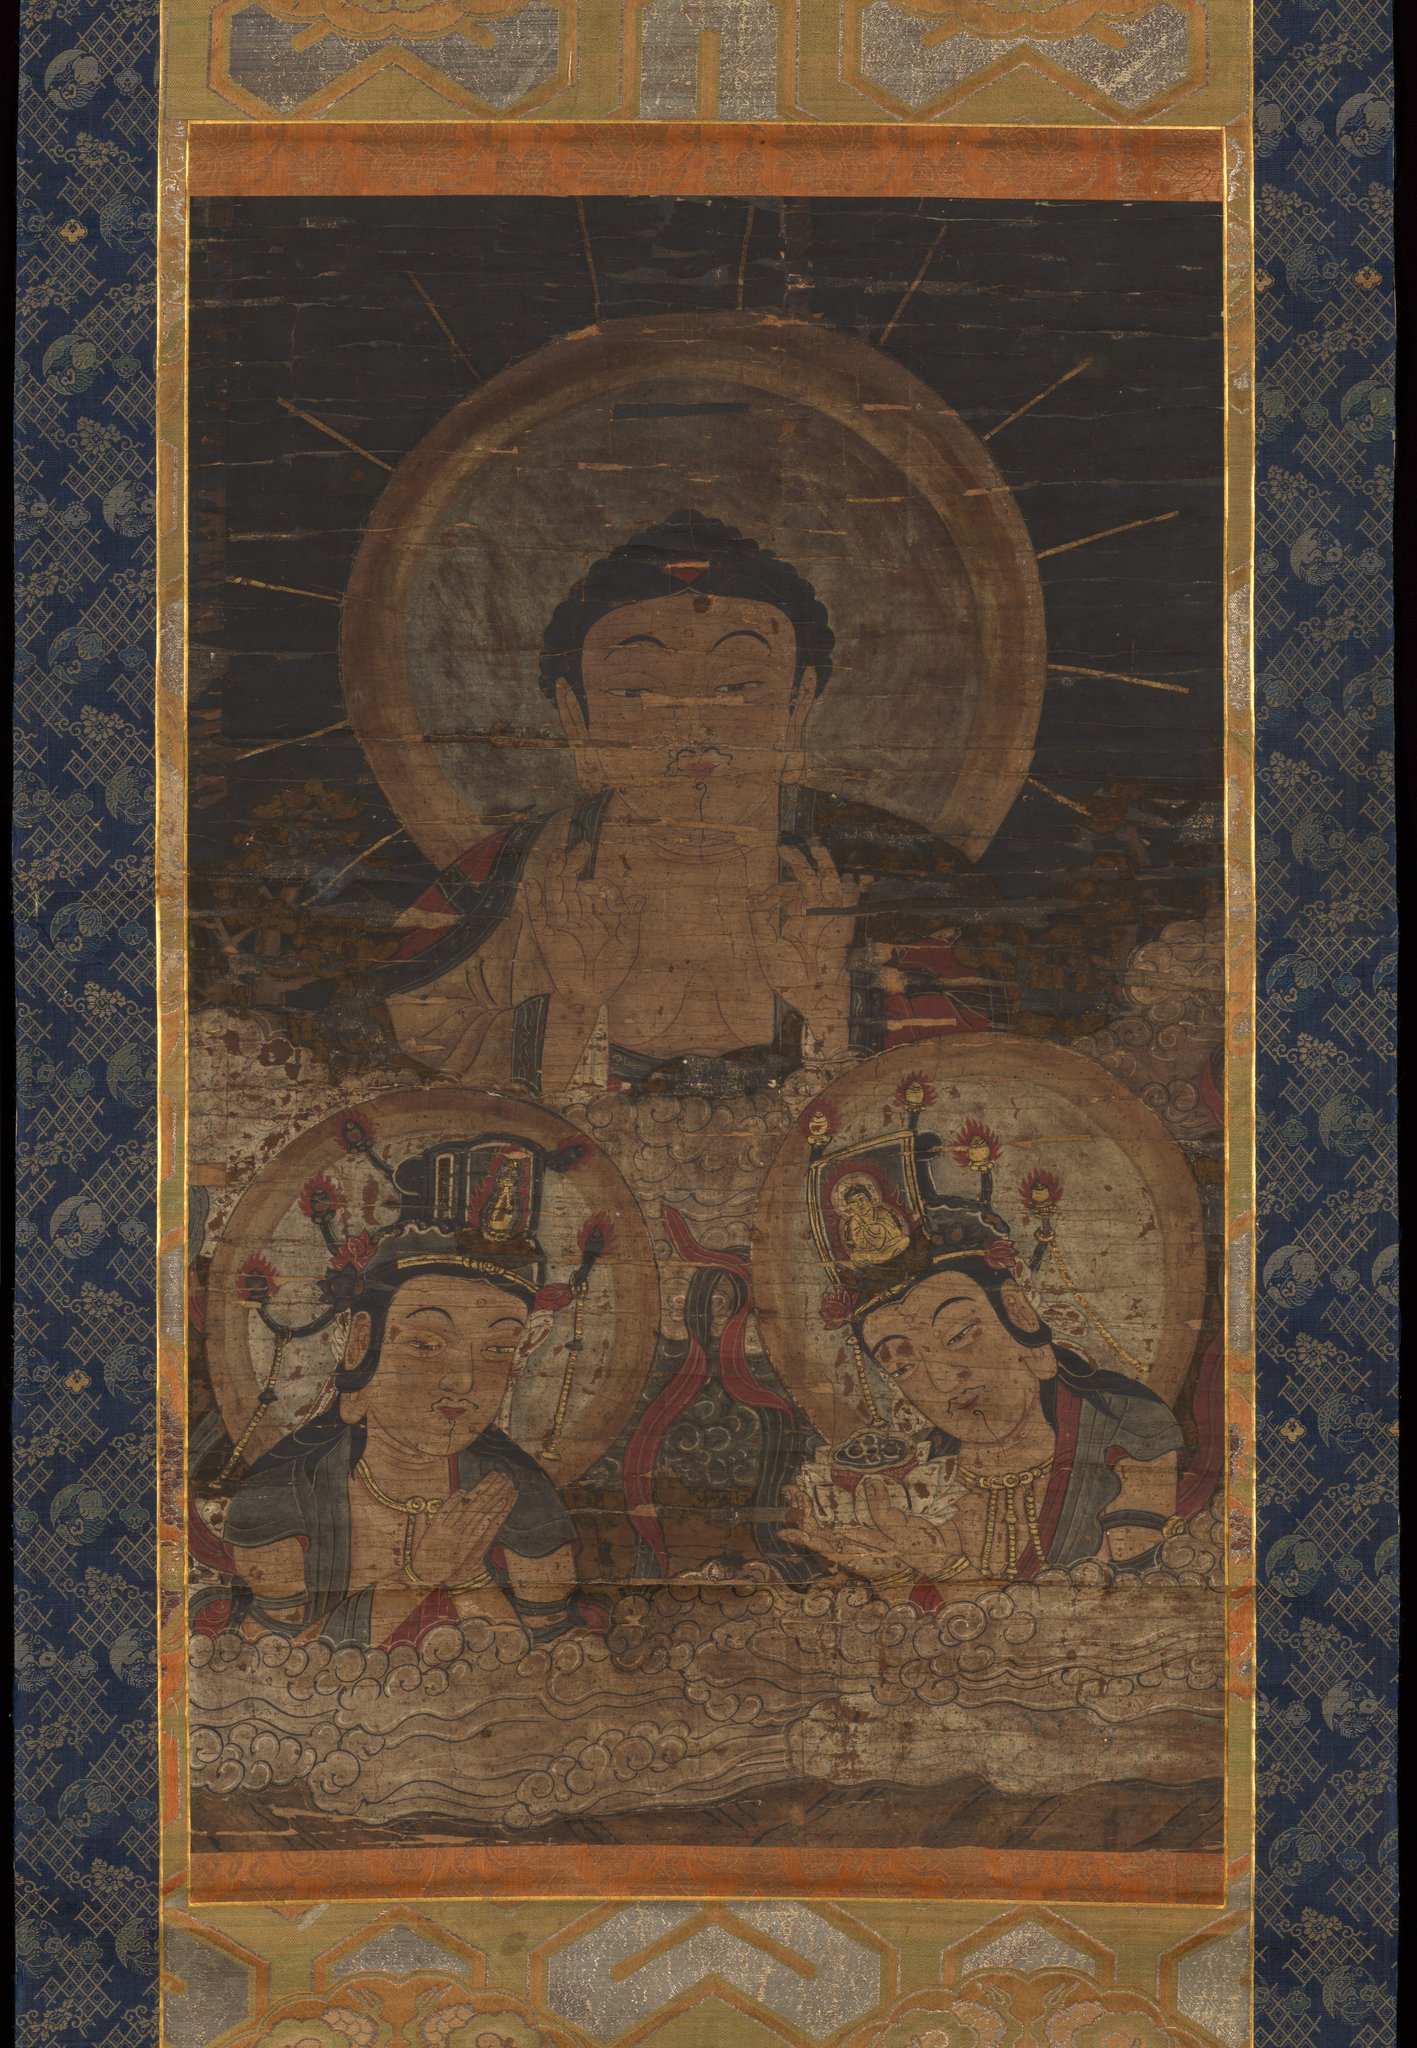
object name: hanging scroll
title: Buddha with Two Attendants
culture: japanese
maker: unidentified artist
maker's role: artist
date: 1501-1700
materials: ink, paper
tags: buddhism,buddha